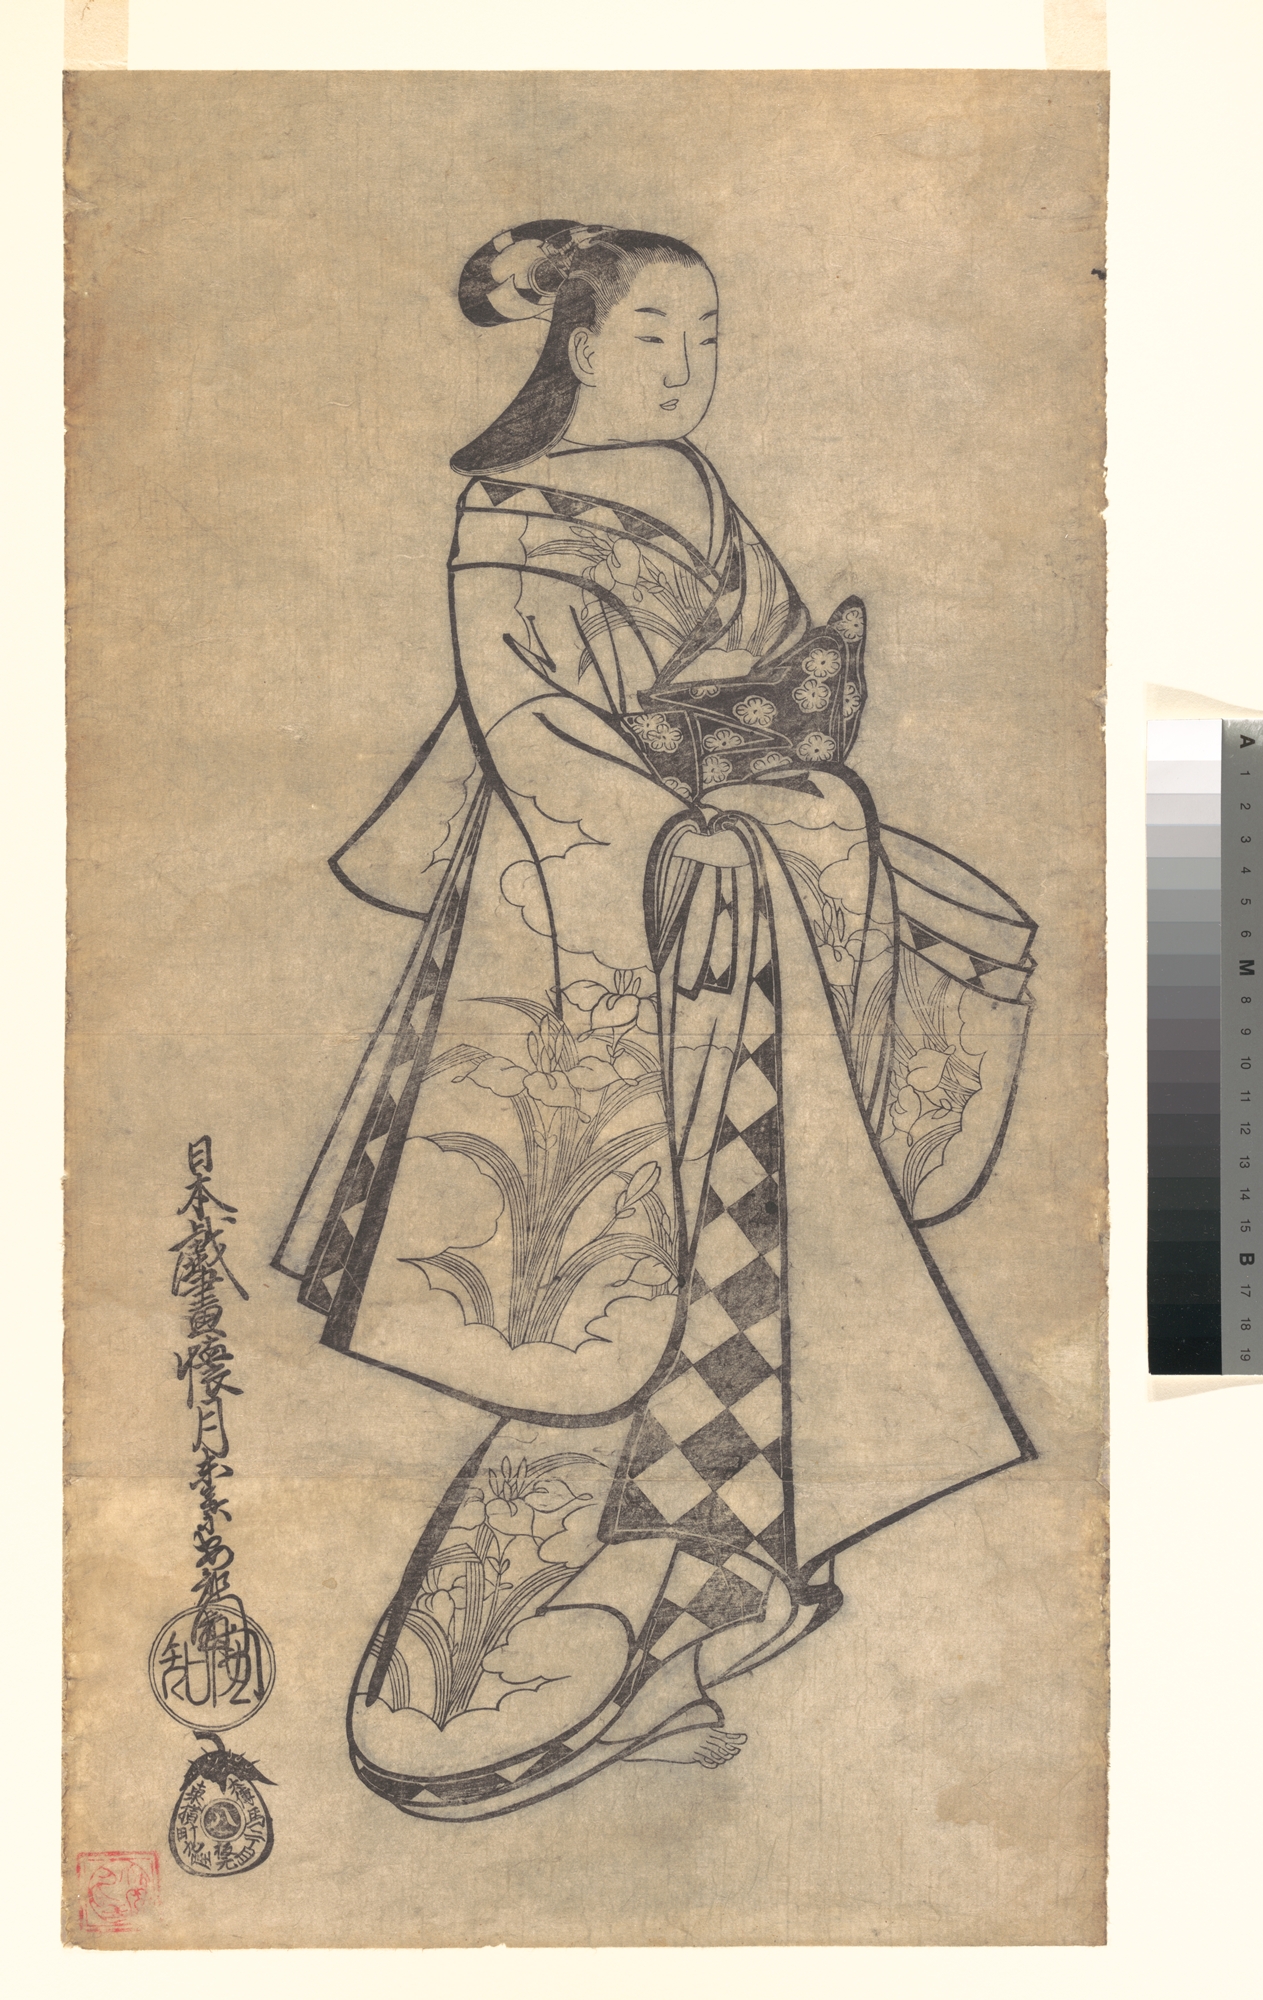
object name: print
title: Courtesan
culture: japanese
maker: kaigetsudō anchi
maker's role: artist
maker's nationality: japanese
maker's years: 1714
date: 1714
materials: ink, paper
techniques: sumizuri, woodblock print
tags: women